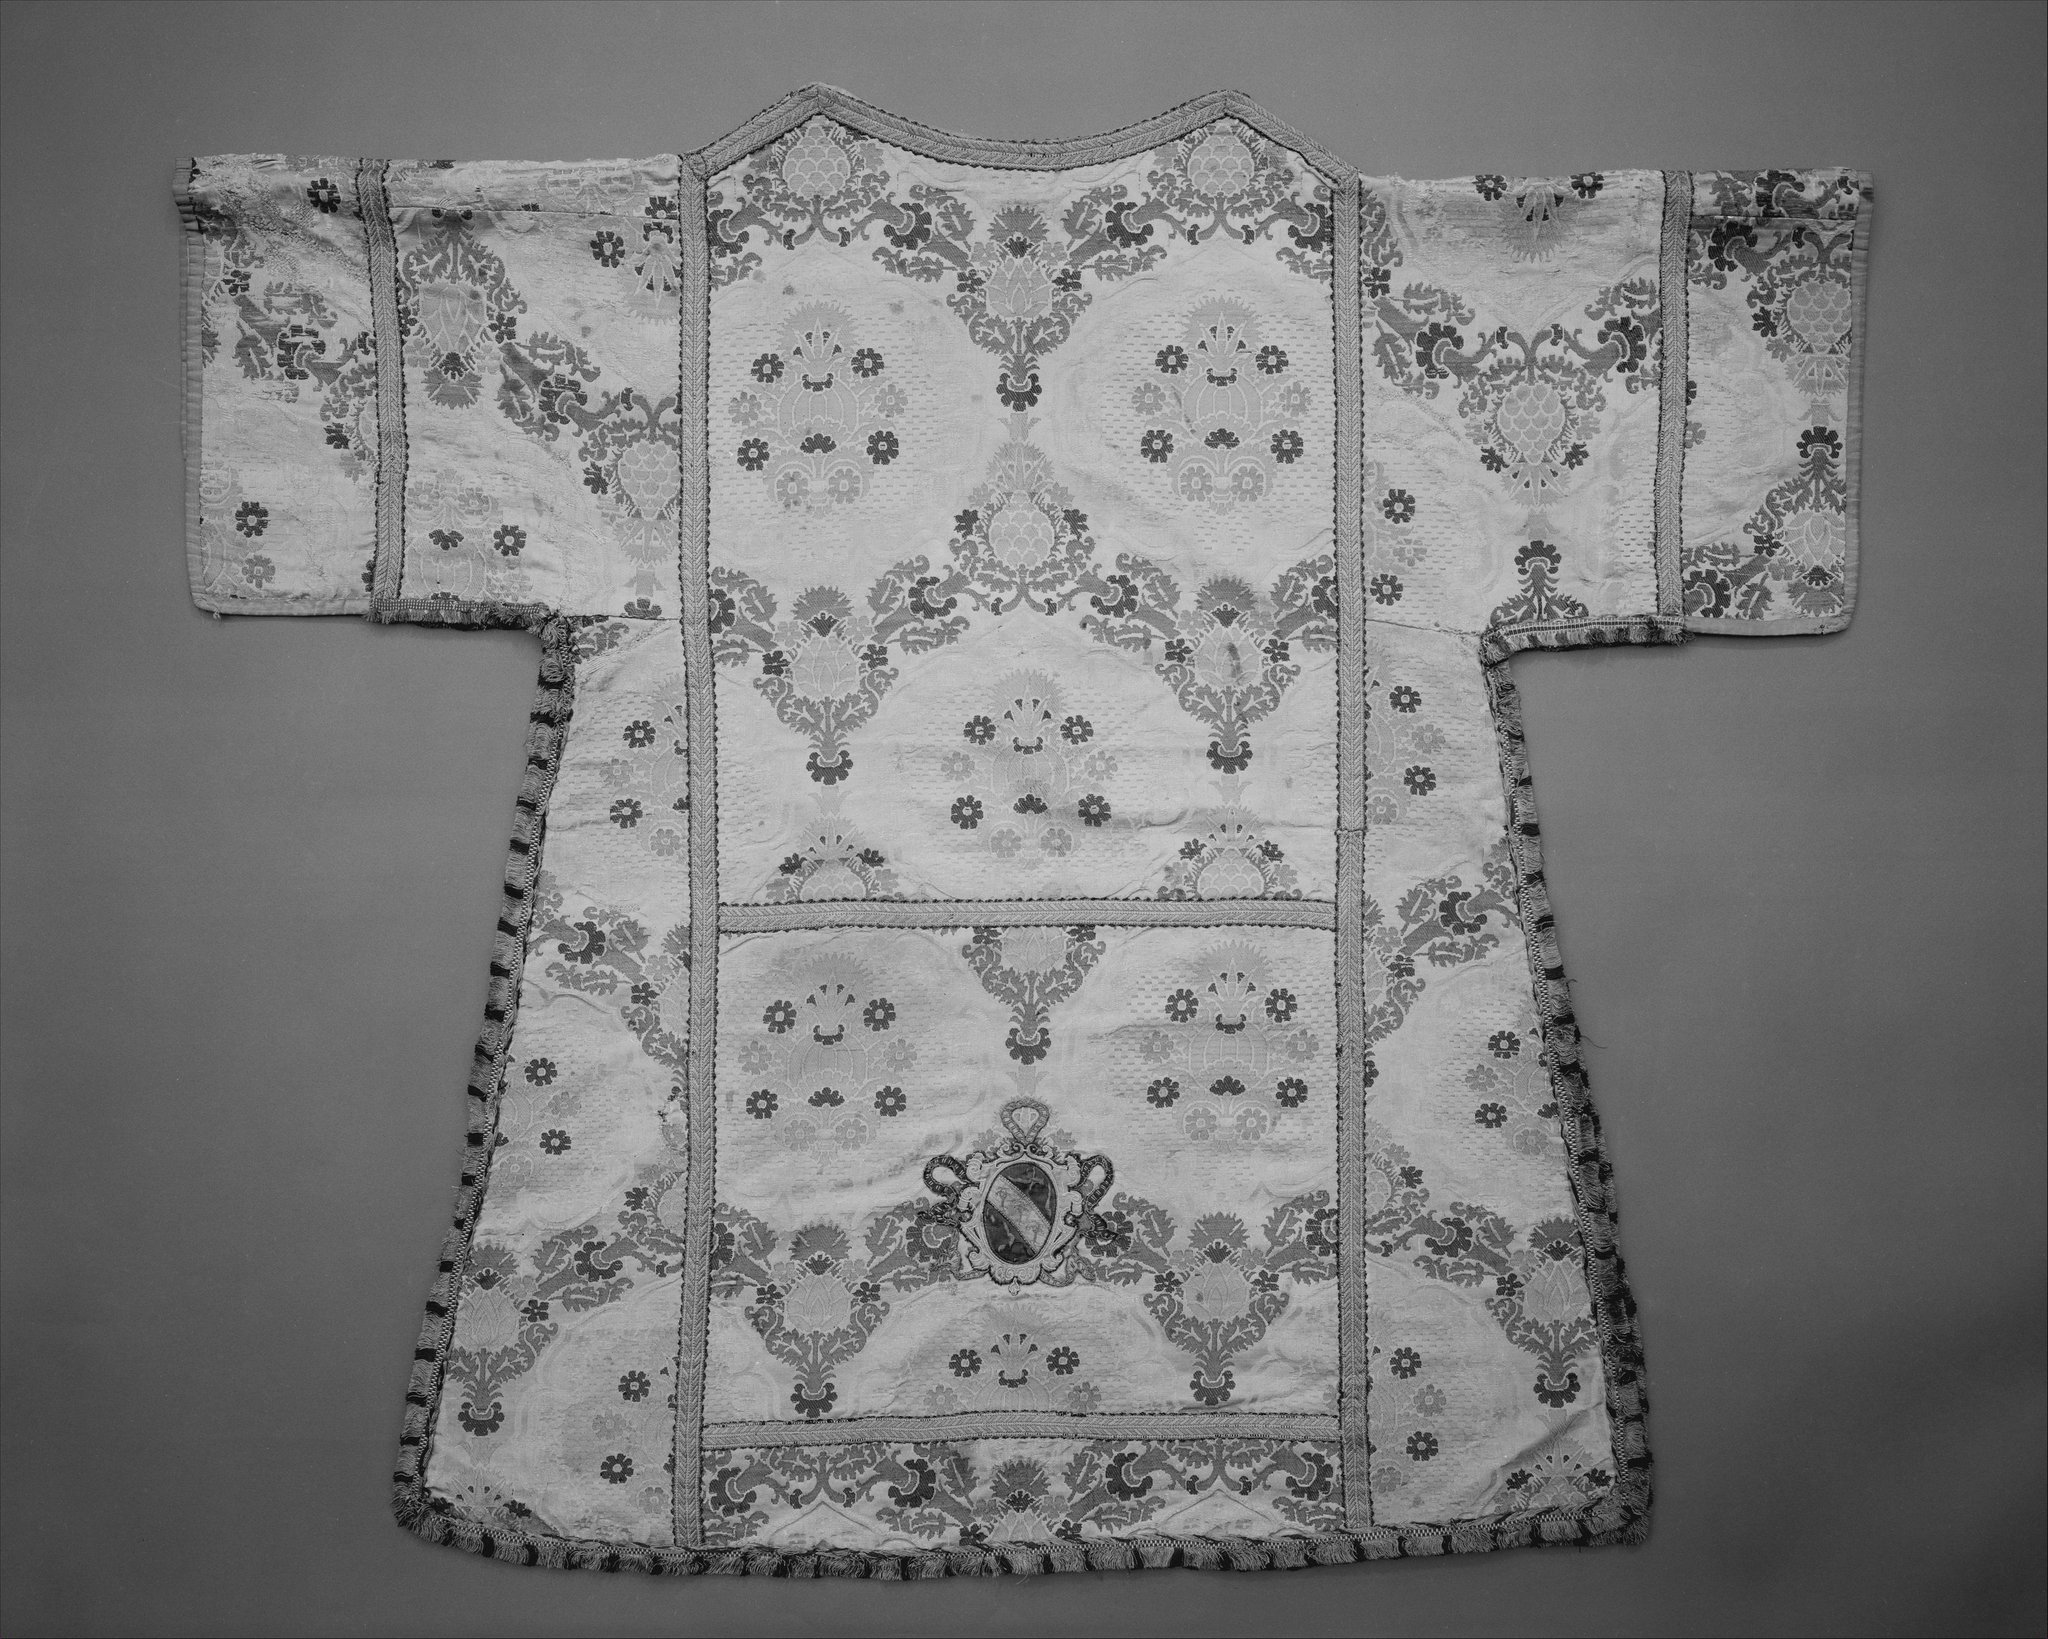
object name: dalmatic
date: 1467-1533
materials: silk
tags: flowers